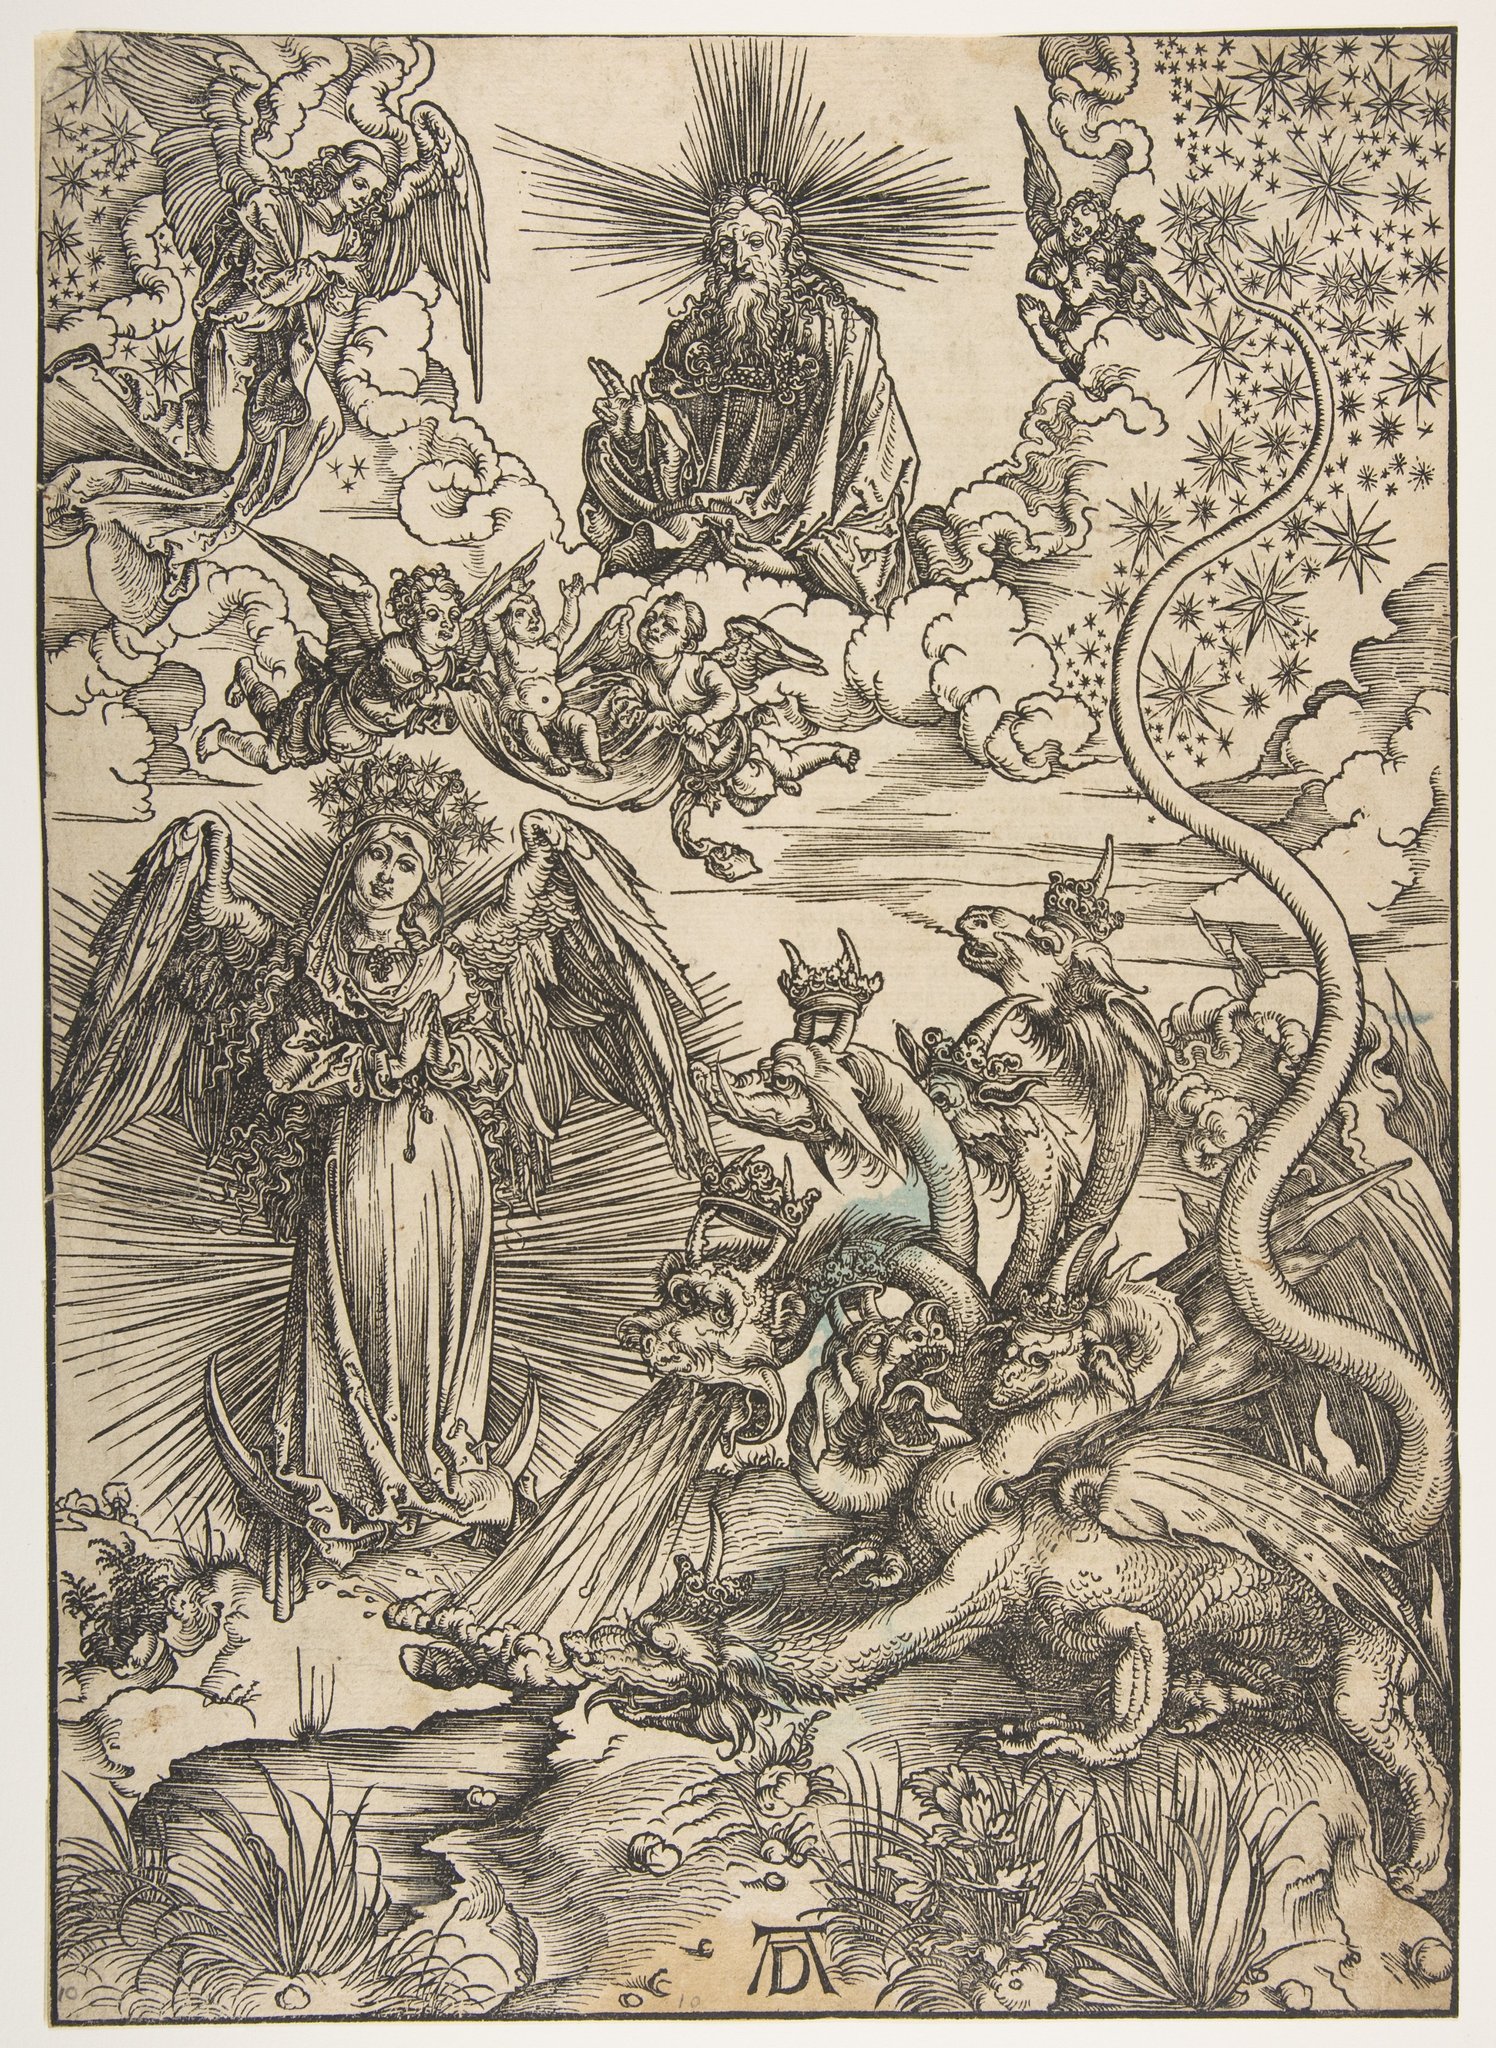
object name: print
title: The Apocalyptic Woman, from "The Apocalypse", Latin Edition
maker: albrecht dürer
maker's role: artist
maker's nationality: german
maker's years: 1471-1528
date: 1511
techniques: woodcut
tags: angels,apocalypse